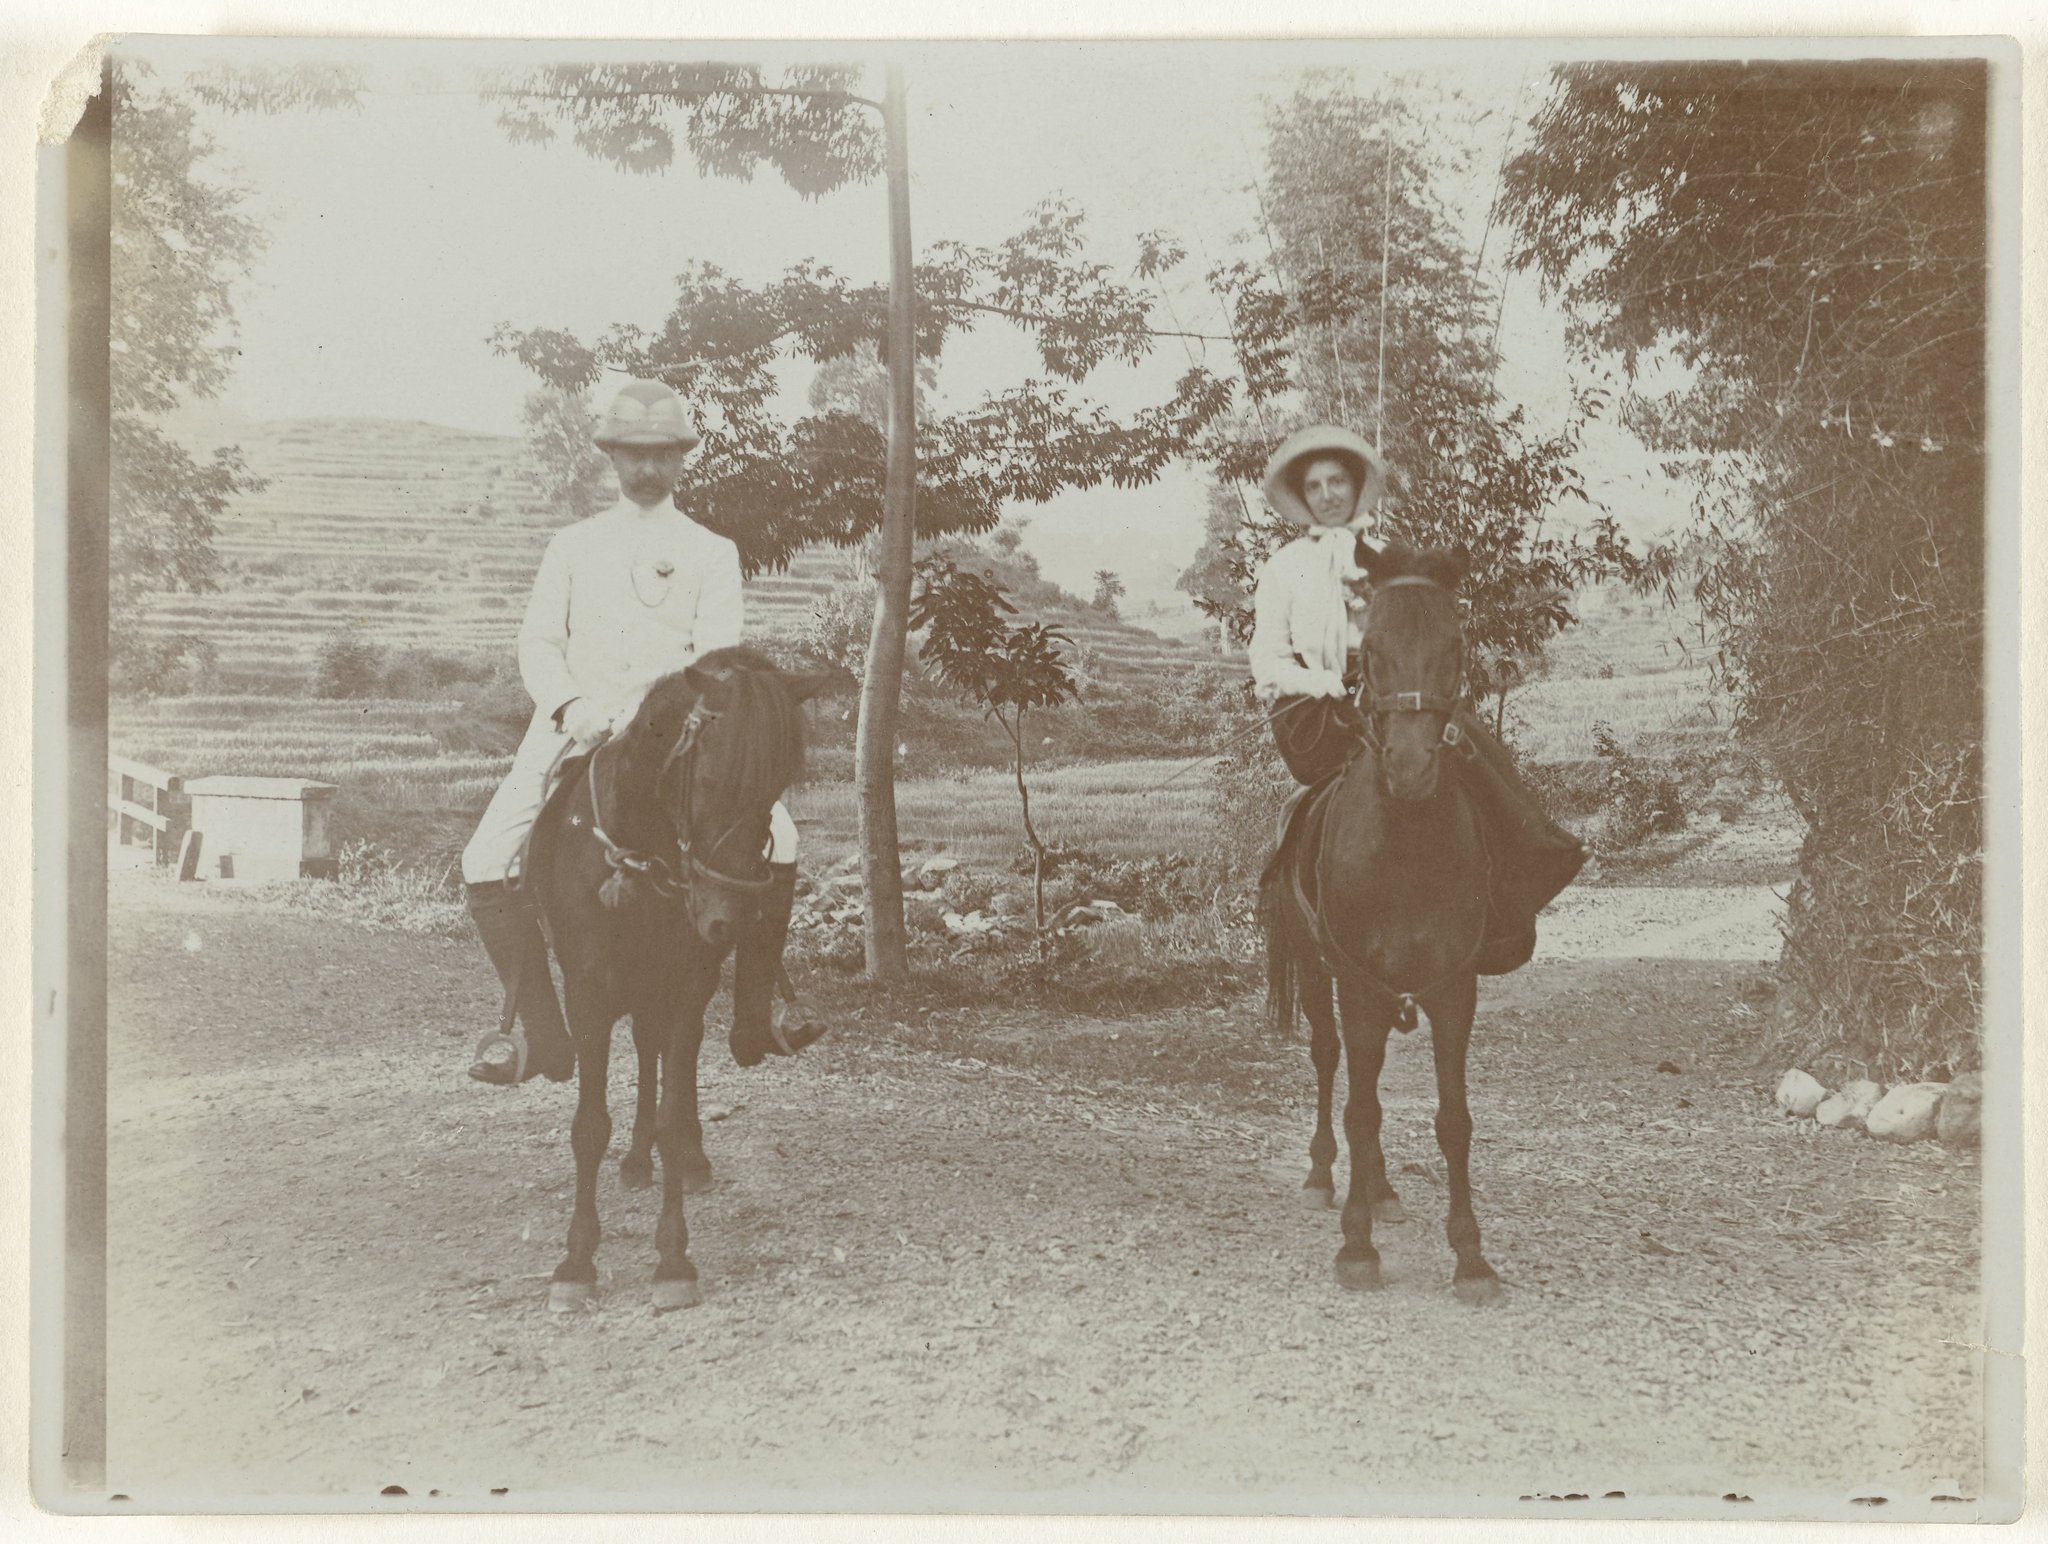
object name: photograph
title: Het echtpaar Letterie te paard in de natuur te Patjet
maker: Anonymous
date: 1906-1913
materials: photographic support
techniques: photography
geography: dutch east indies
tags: riding a horse, ass, or mule; rider, horseman, dutch east indies, the